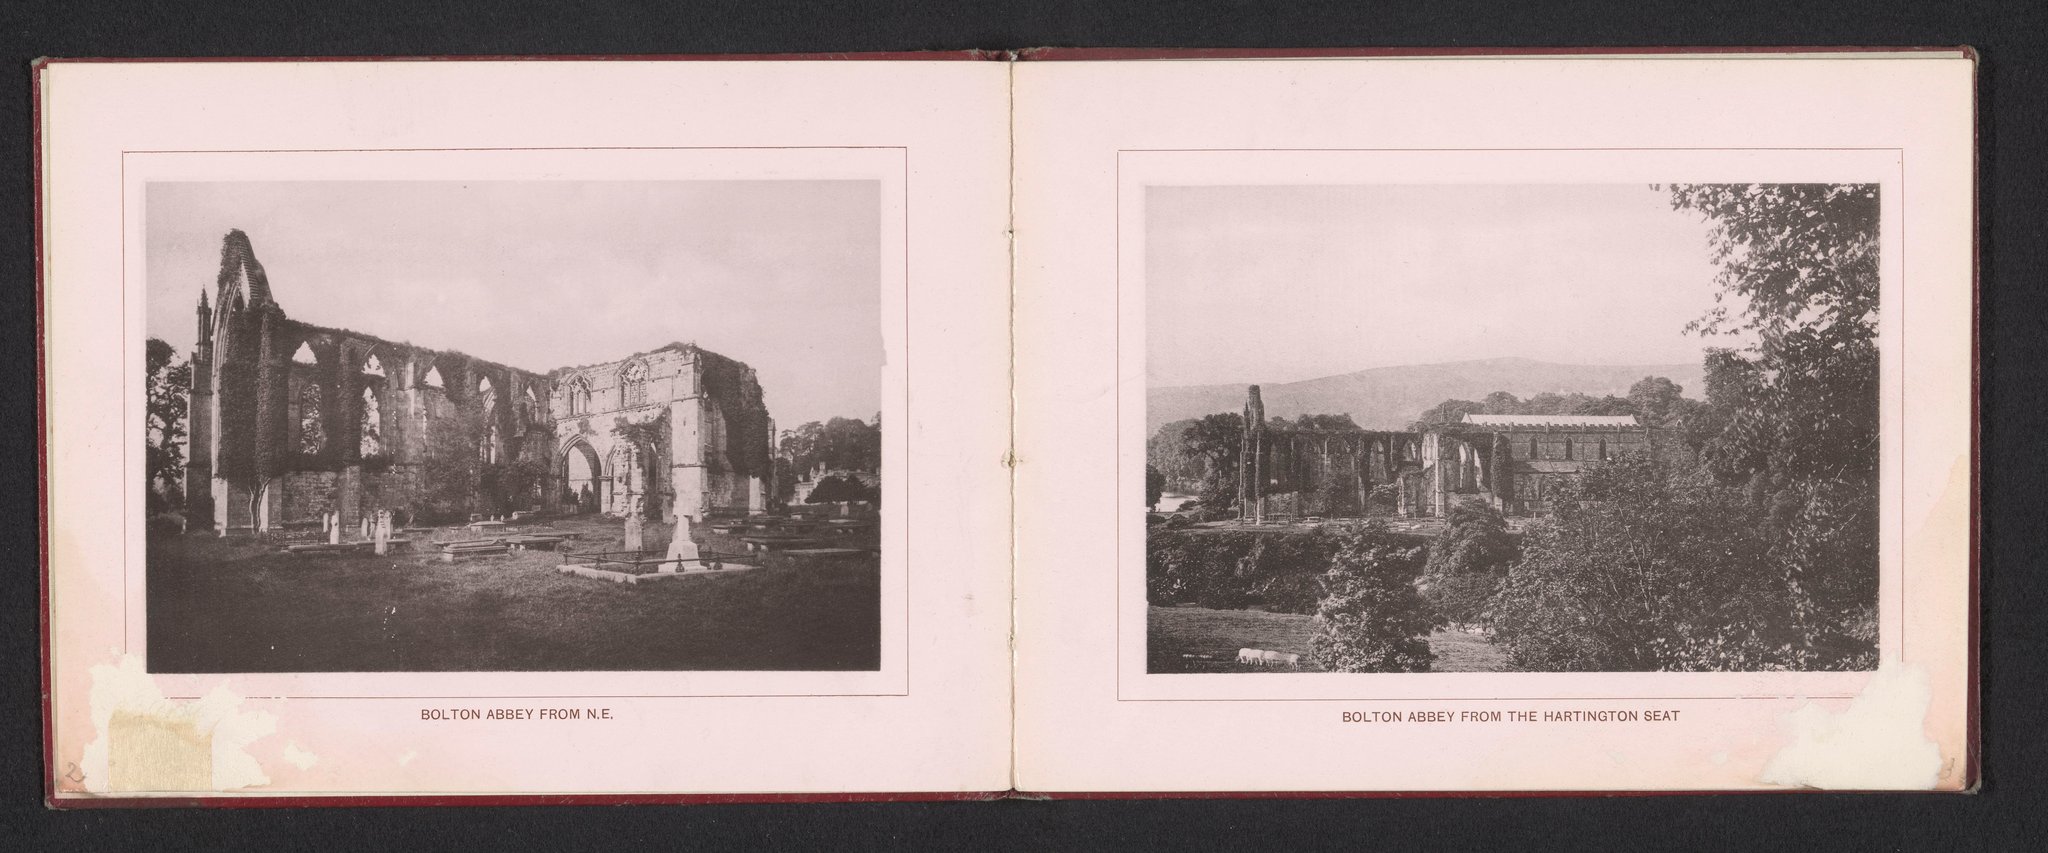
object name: page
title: Bolton Abbey from the Hartington Seat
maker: Anonymous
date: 1890-1900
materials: linen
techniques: photograph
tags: ruin of church, monastery, etc.